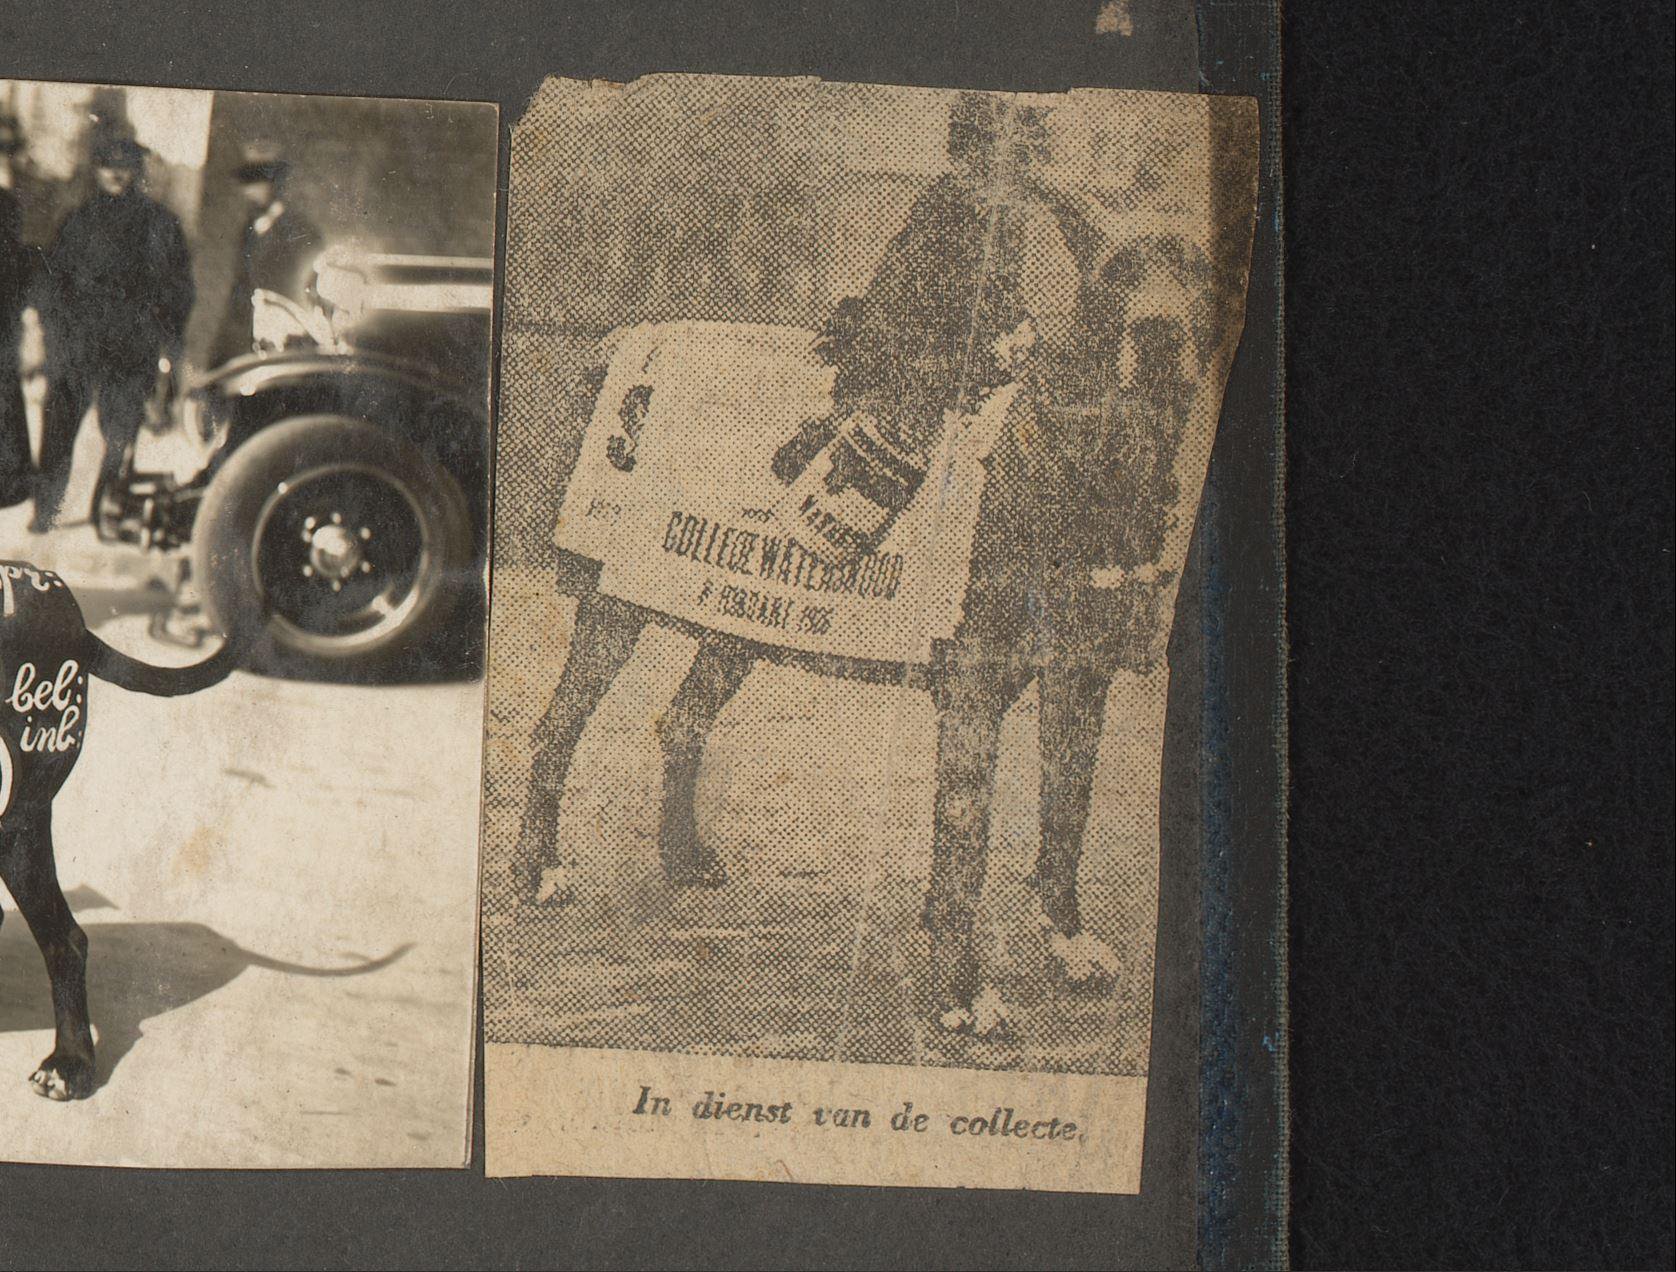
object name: newspaper clipping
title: Hond van de poppendokter met reclametekst voor een collecte voor watersnood en een pop op de rug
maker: Anonymous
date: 1930-1940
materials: paper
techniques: autotype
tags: advertising, dolls for adults, dog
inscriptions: inscription: ‘In dienst van de collecte’